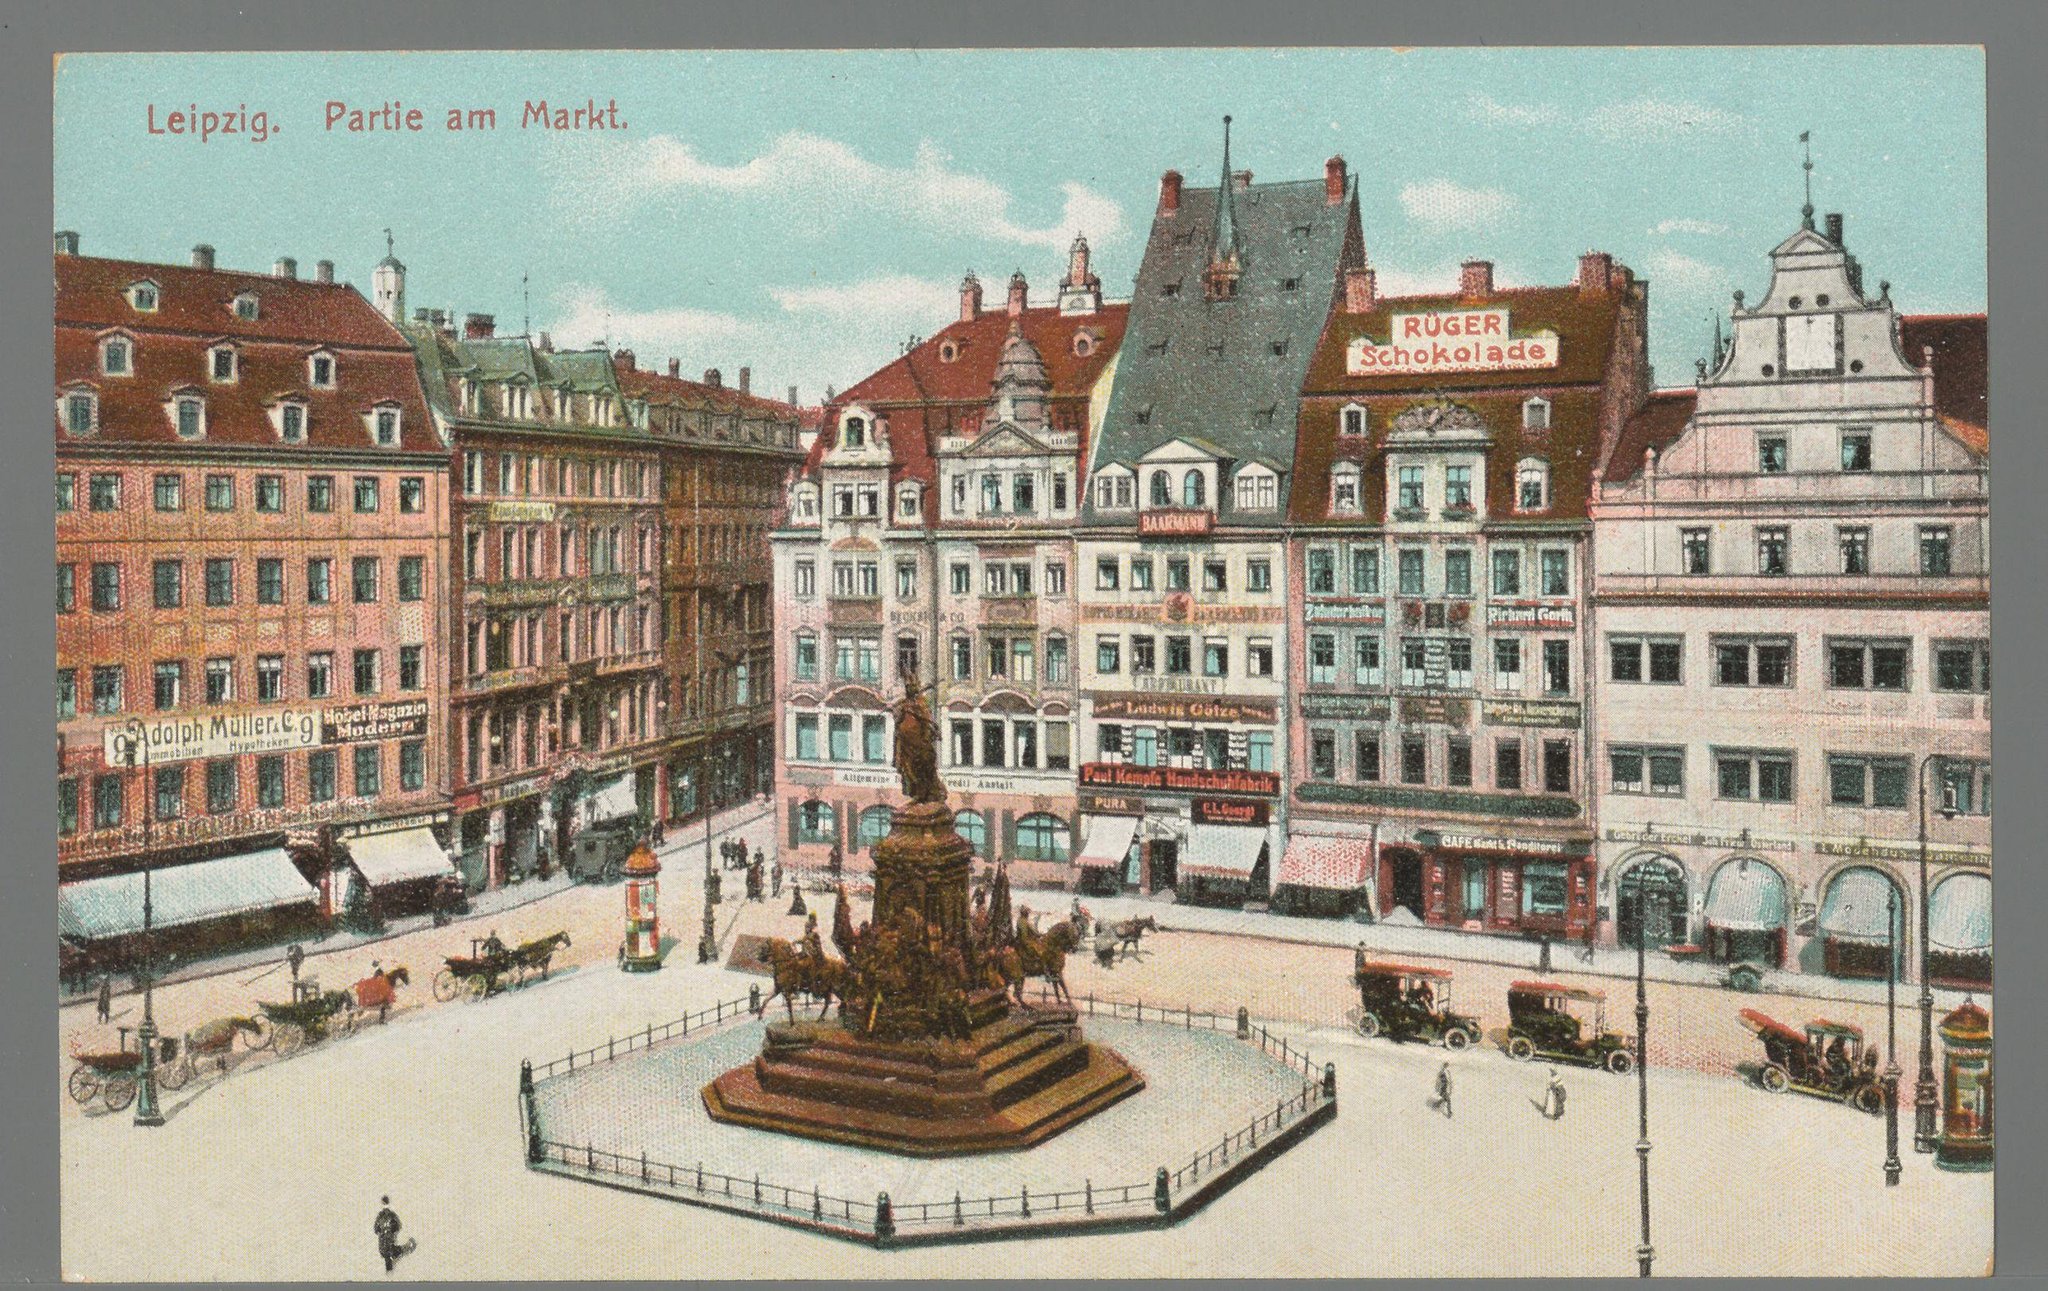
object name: photomechanical print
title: Leipzig. Partie am Markt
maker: Anonymous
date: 1905-1909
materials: cardboard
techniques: lithograph, writing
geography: leipzig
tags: square, place, circus, etc., monument, statue